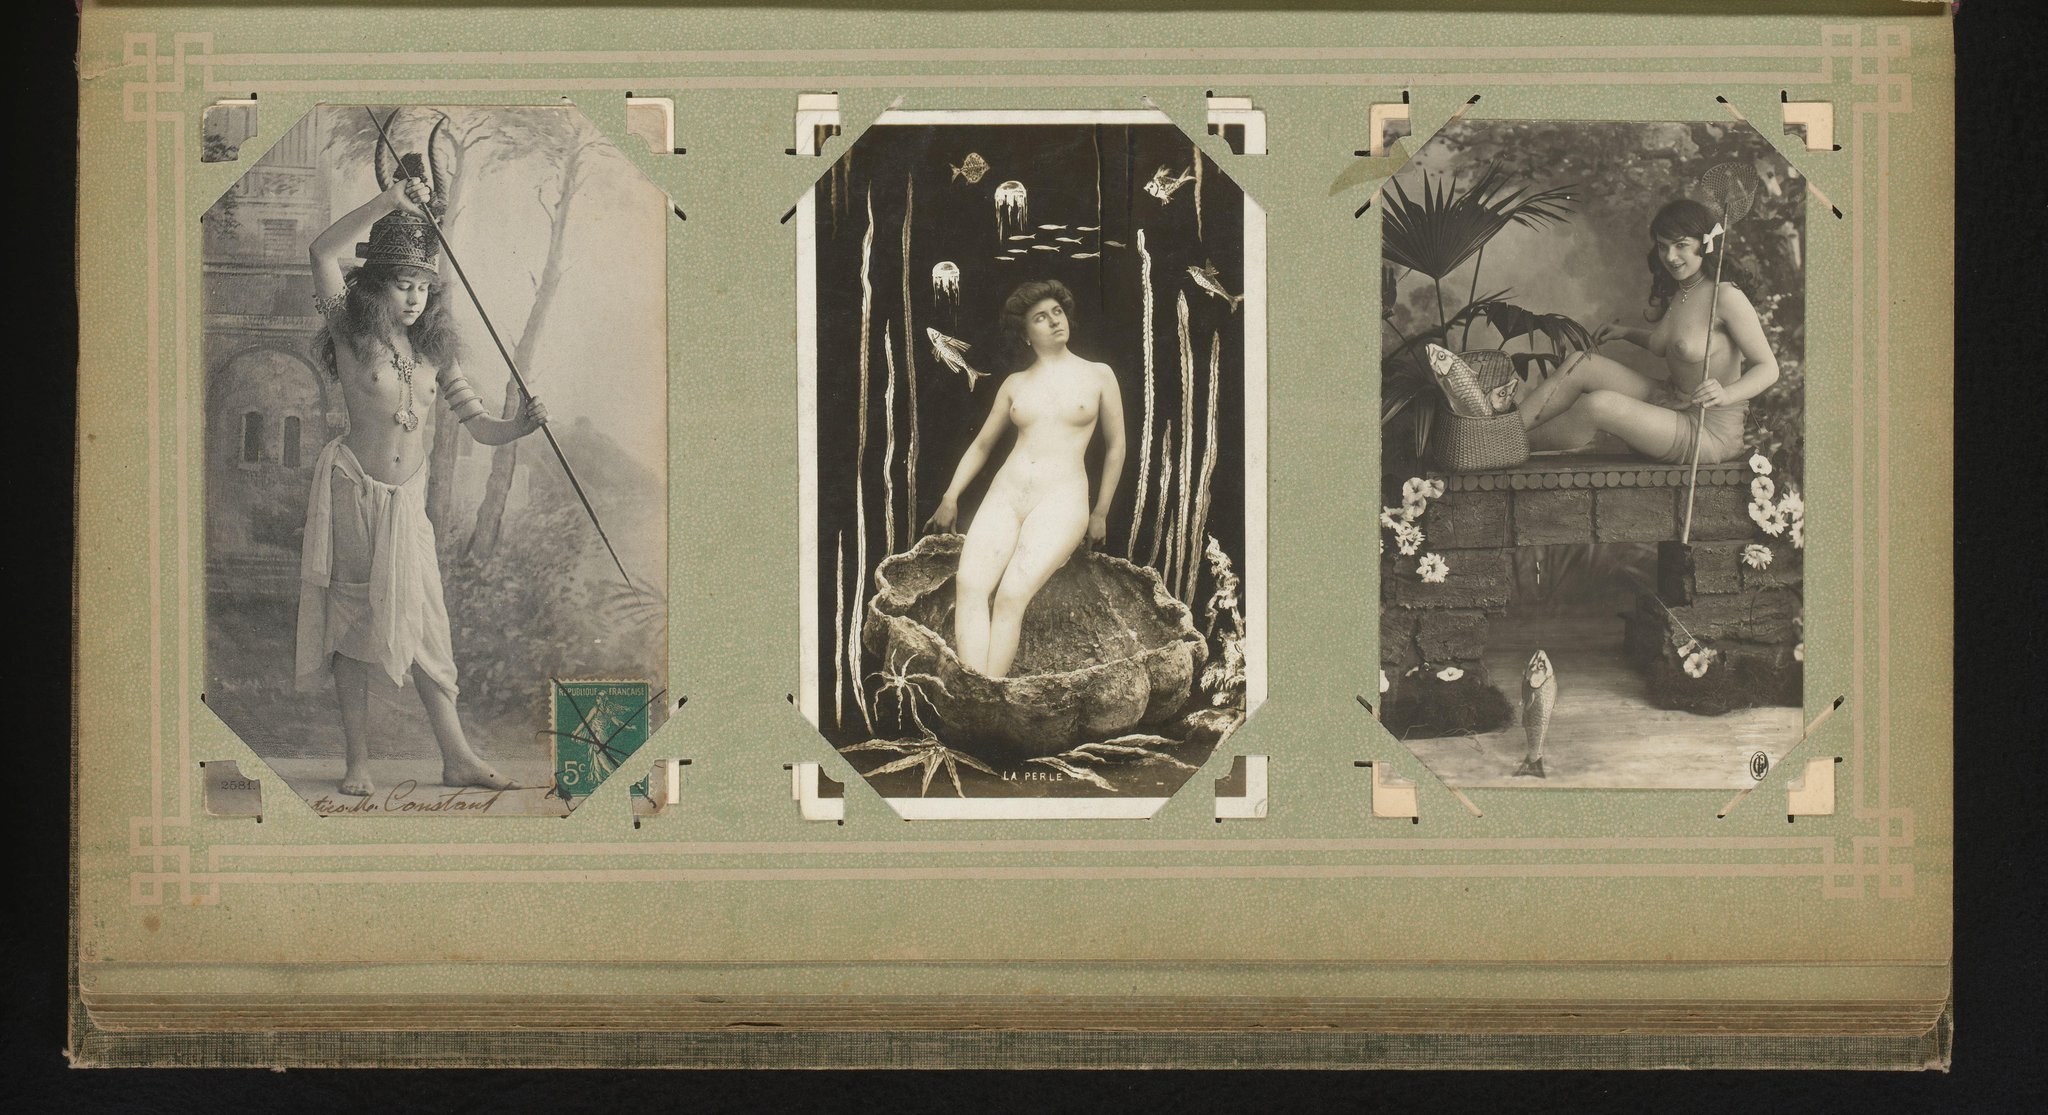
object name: photomechanical print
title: Drie portretten van naakte vrouwen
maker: Anonymous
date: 1900-1930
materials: cardboard, ink, photographic support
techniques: photograph, gelatin silver print, pen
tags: historical persons - bb - woman, fishes, woman (showing herself) undressed, quasi-nude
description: Deze foto's en prent maken deel uit van een album.